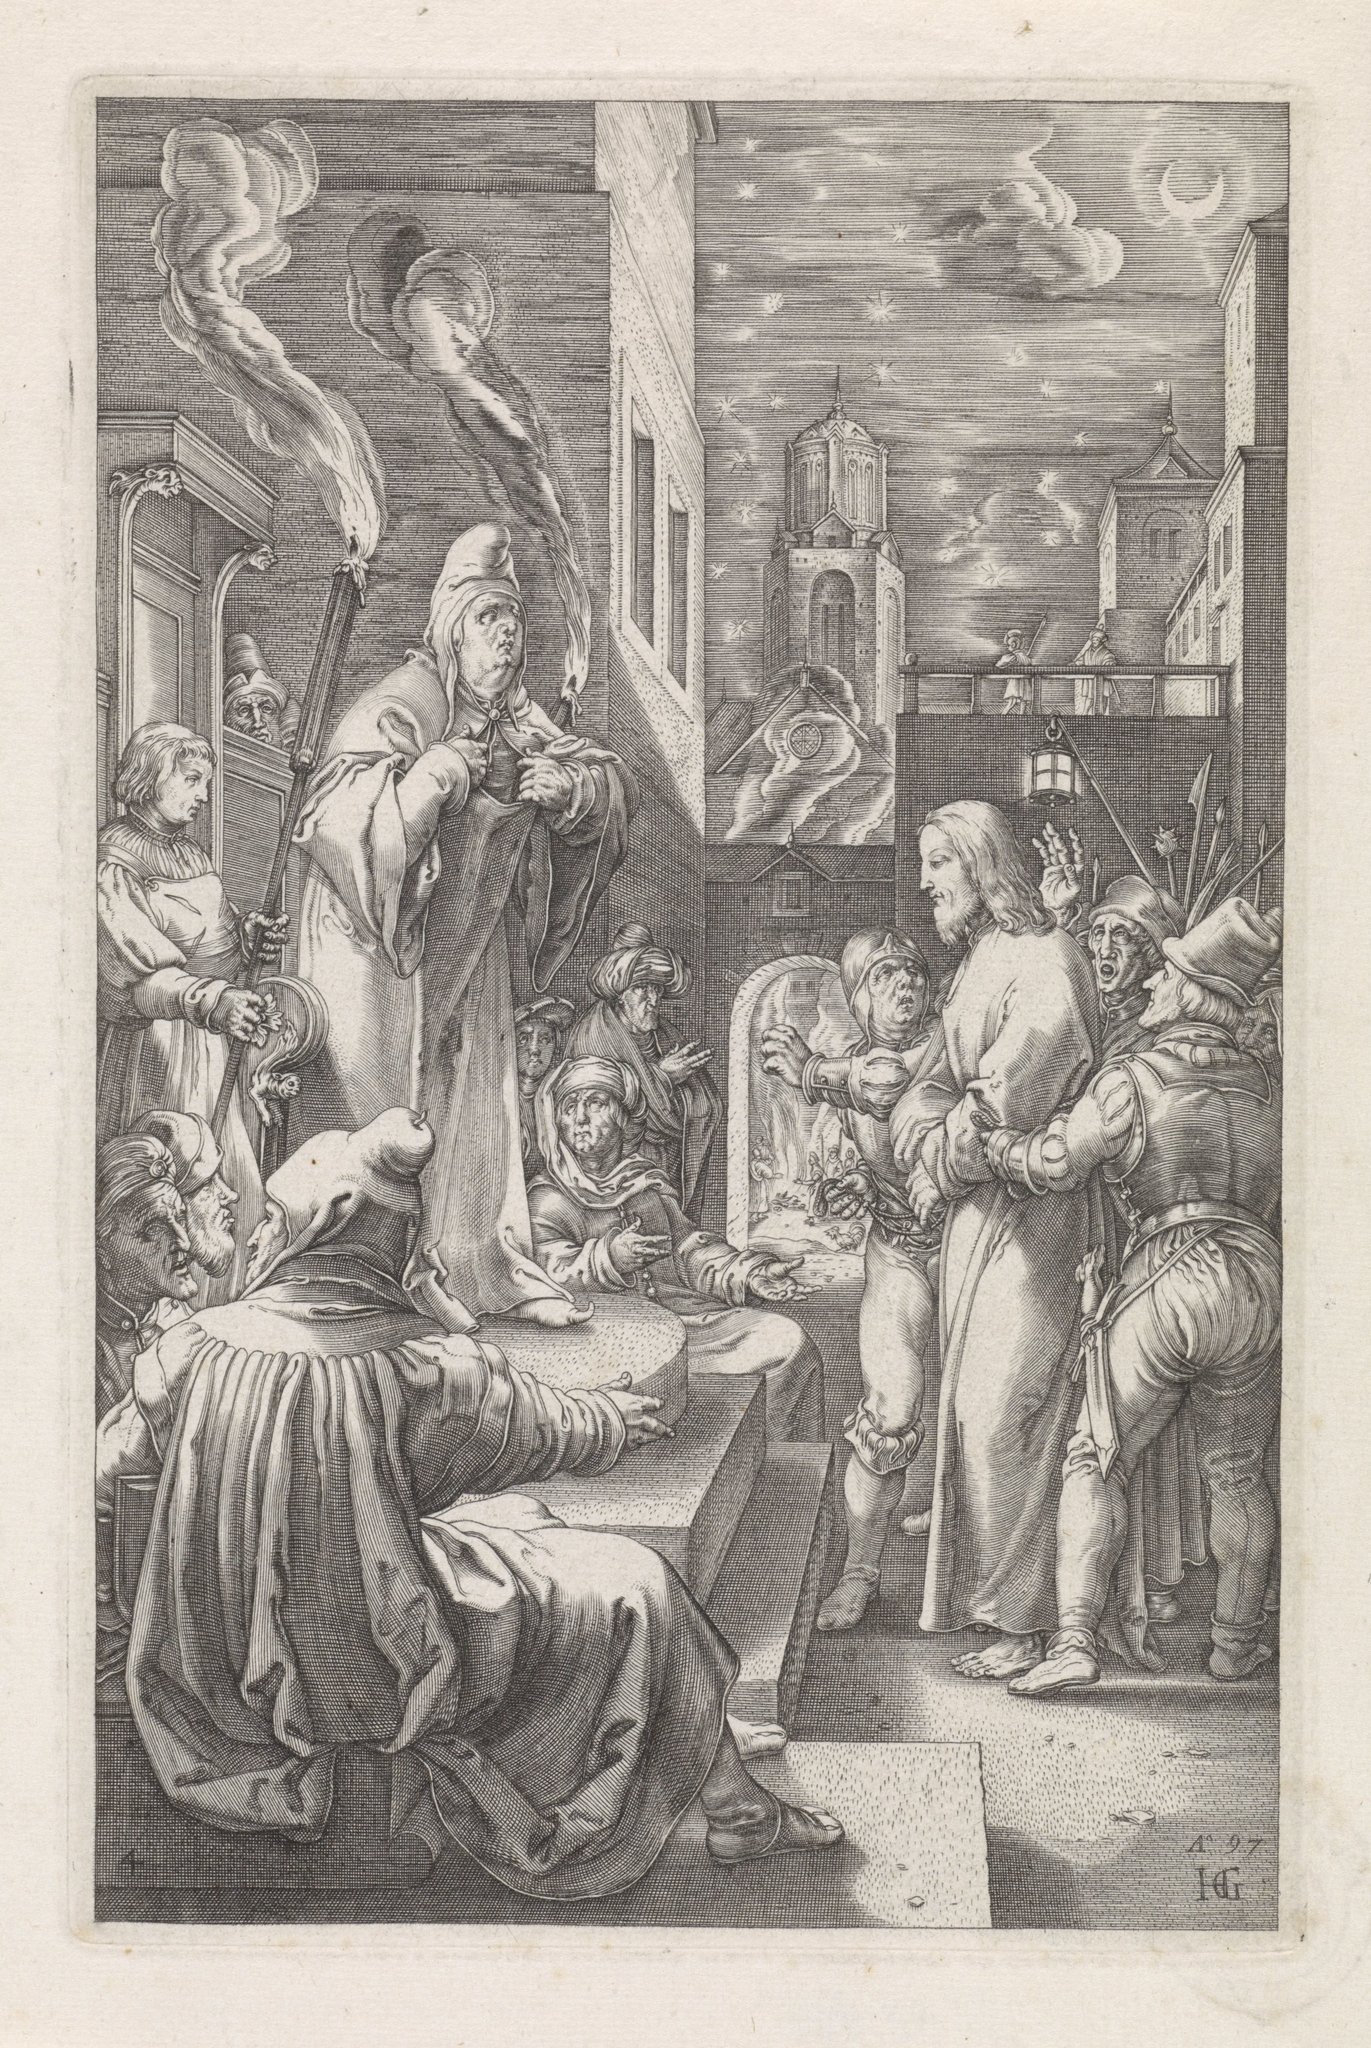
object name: print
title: Christus voor Kajafas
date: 1597-1667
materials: paper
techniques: engraving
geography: netherlands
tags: christ before the sanhedrin with caiaphas as high priest, and possibly annas; maybe a soldier about to strike christ because he keeps silent (matthew 26:57-66; mark 14:53-64; luke 22:54, 22:66-71)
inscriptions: collector's mark: Lugt 240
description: Christus wordt voorgeleid aan de hogepriester Kajafas. Kajafas staat op een verhoging tussen twee fakkels en scheurt zijn kleed. Door de poort is het vuur op de binnenplaats zichtbaar waar Petrus zit.